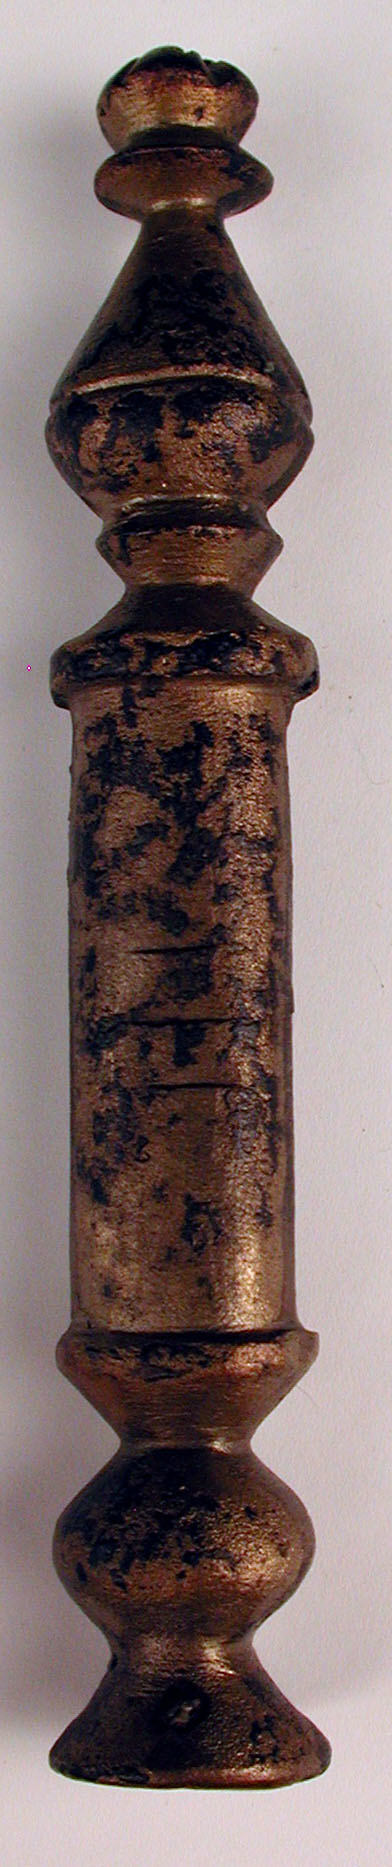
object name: support fitting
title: Baluster Leg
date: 801-1000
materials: bronze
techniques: casting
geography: iran